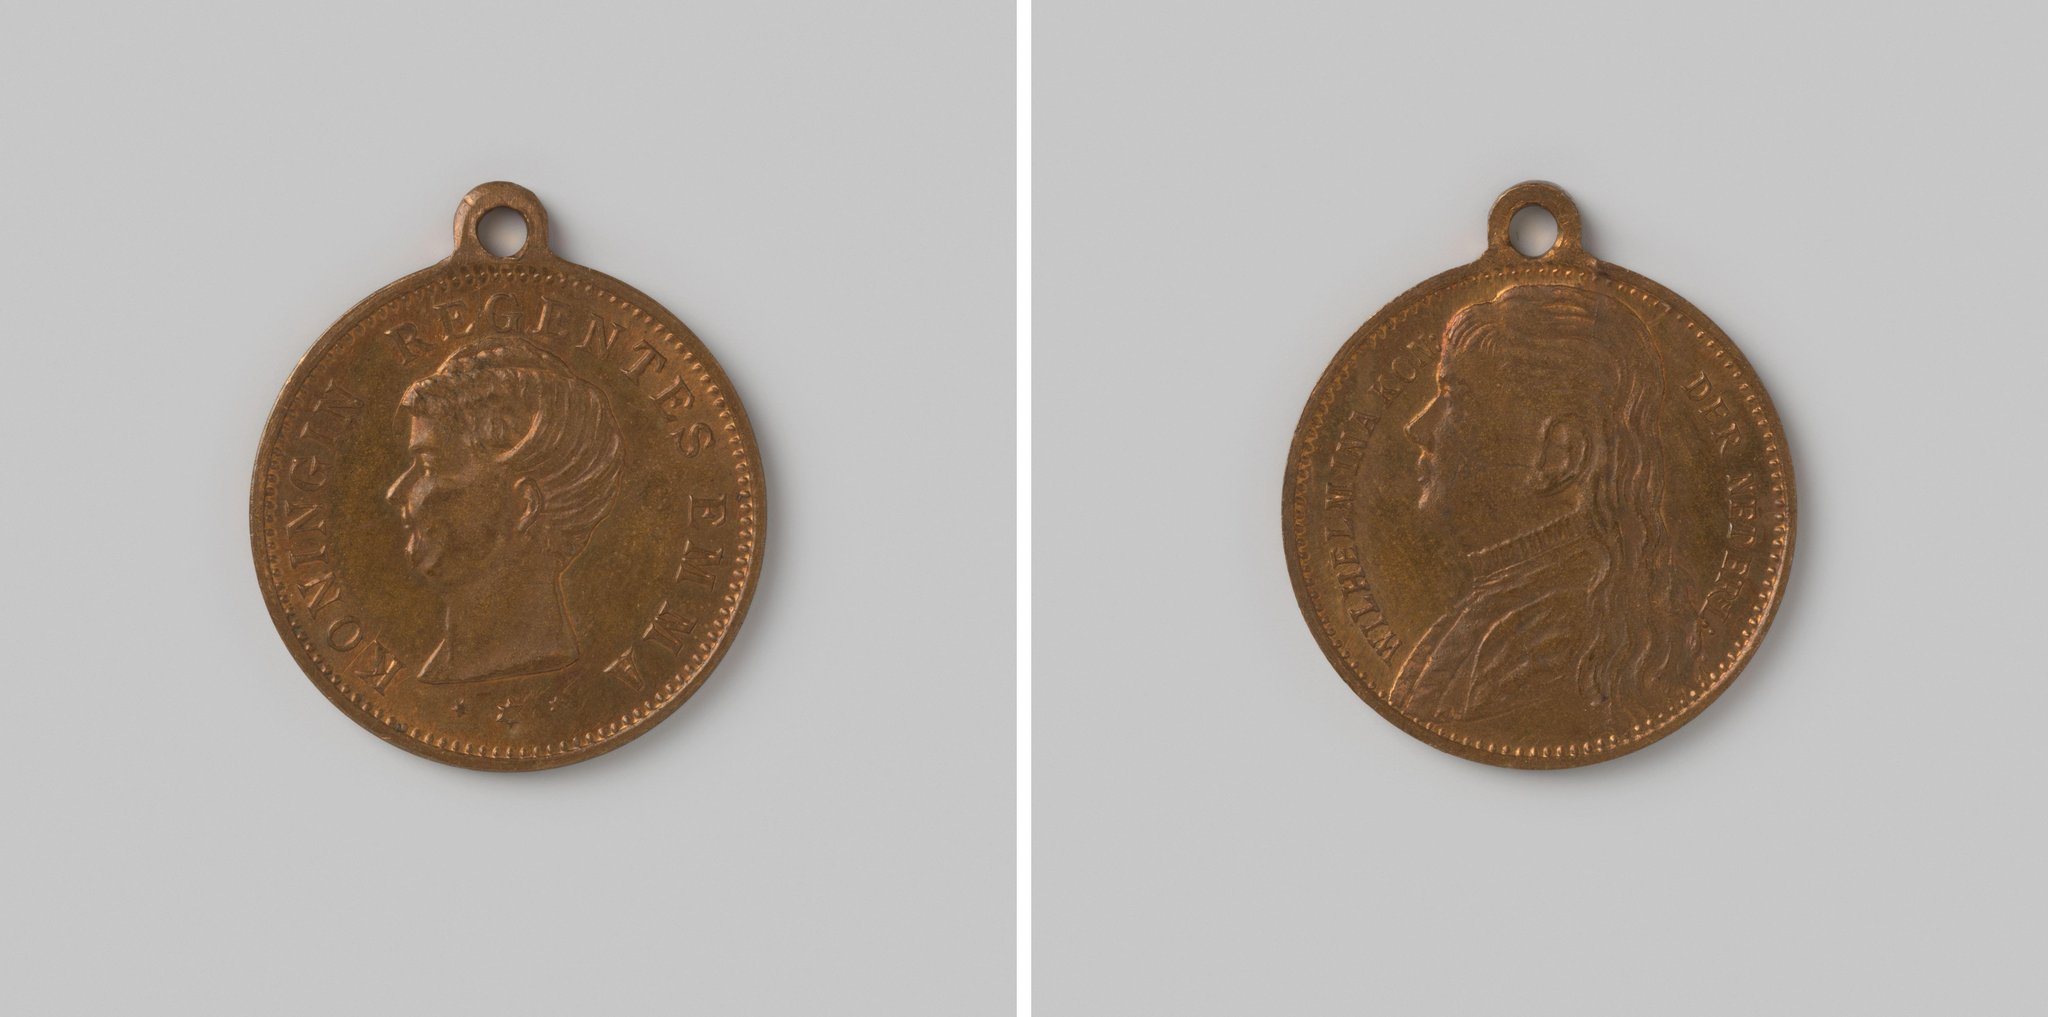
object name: history medal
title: Wilhelmina koningin der Nederlanden en Emma koningin-regentes 1890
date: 1890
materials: brass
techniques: striking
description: Messing penning met draagoog, op de voorzijde het borstbeeld van Wilhelmina naar links met omschrift, op de keerzijde het portret van Emma naar links met omschrift.